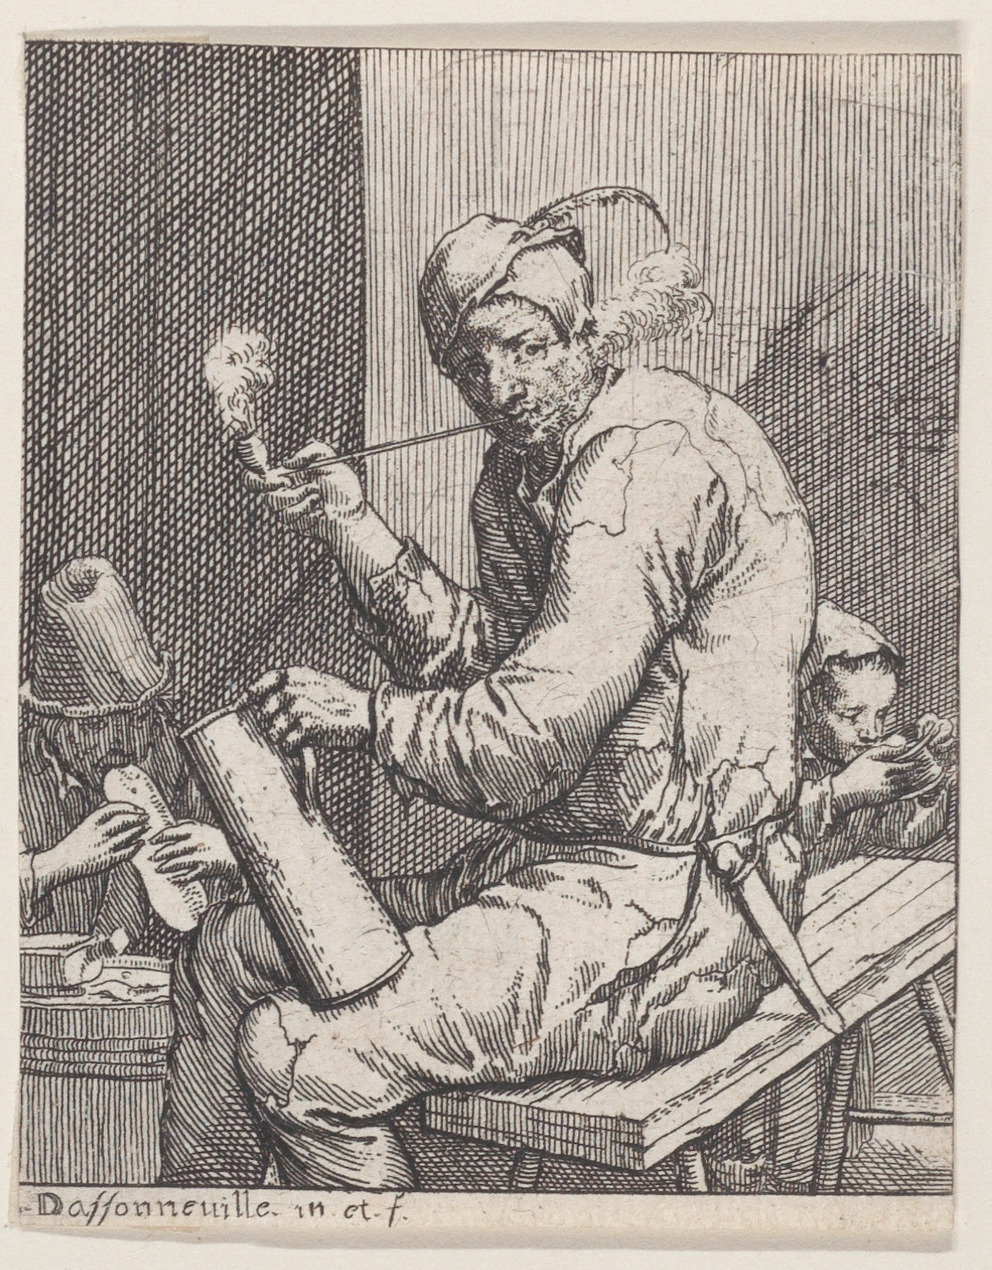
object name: print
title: Man seated smoking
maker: jacques dassonville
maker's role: artist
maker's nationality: french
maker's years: 1614-1675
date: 1640-1670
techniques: etching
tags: men,smoking